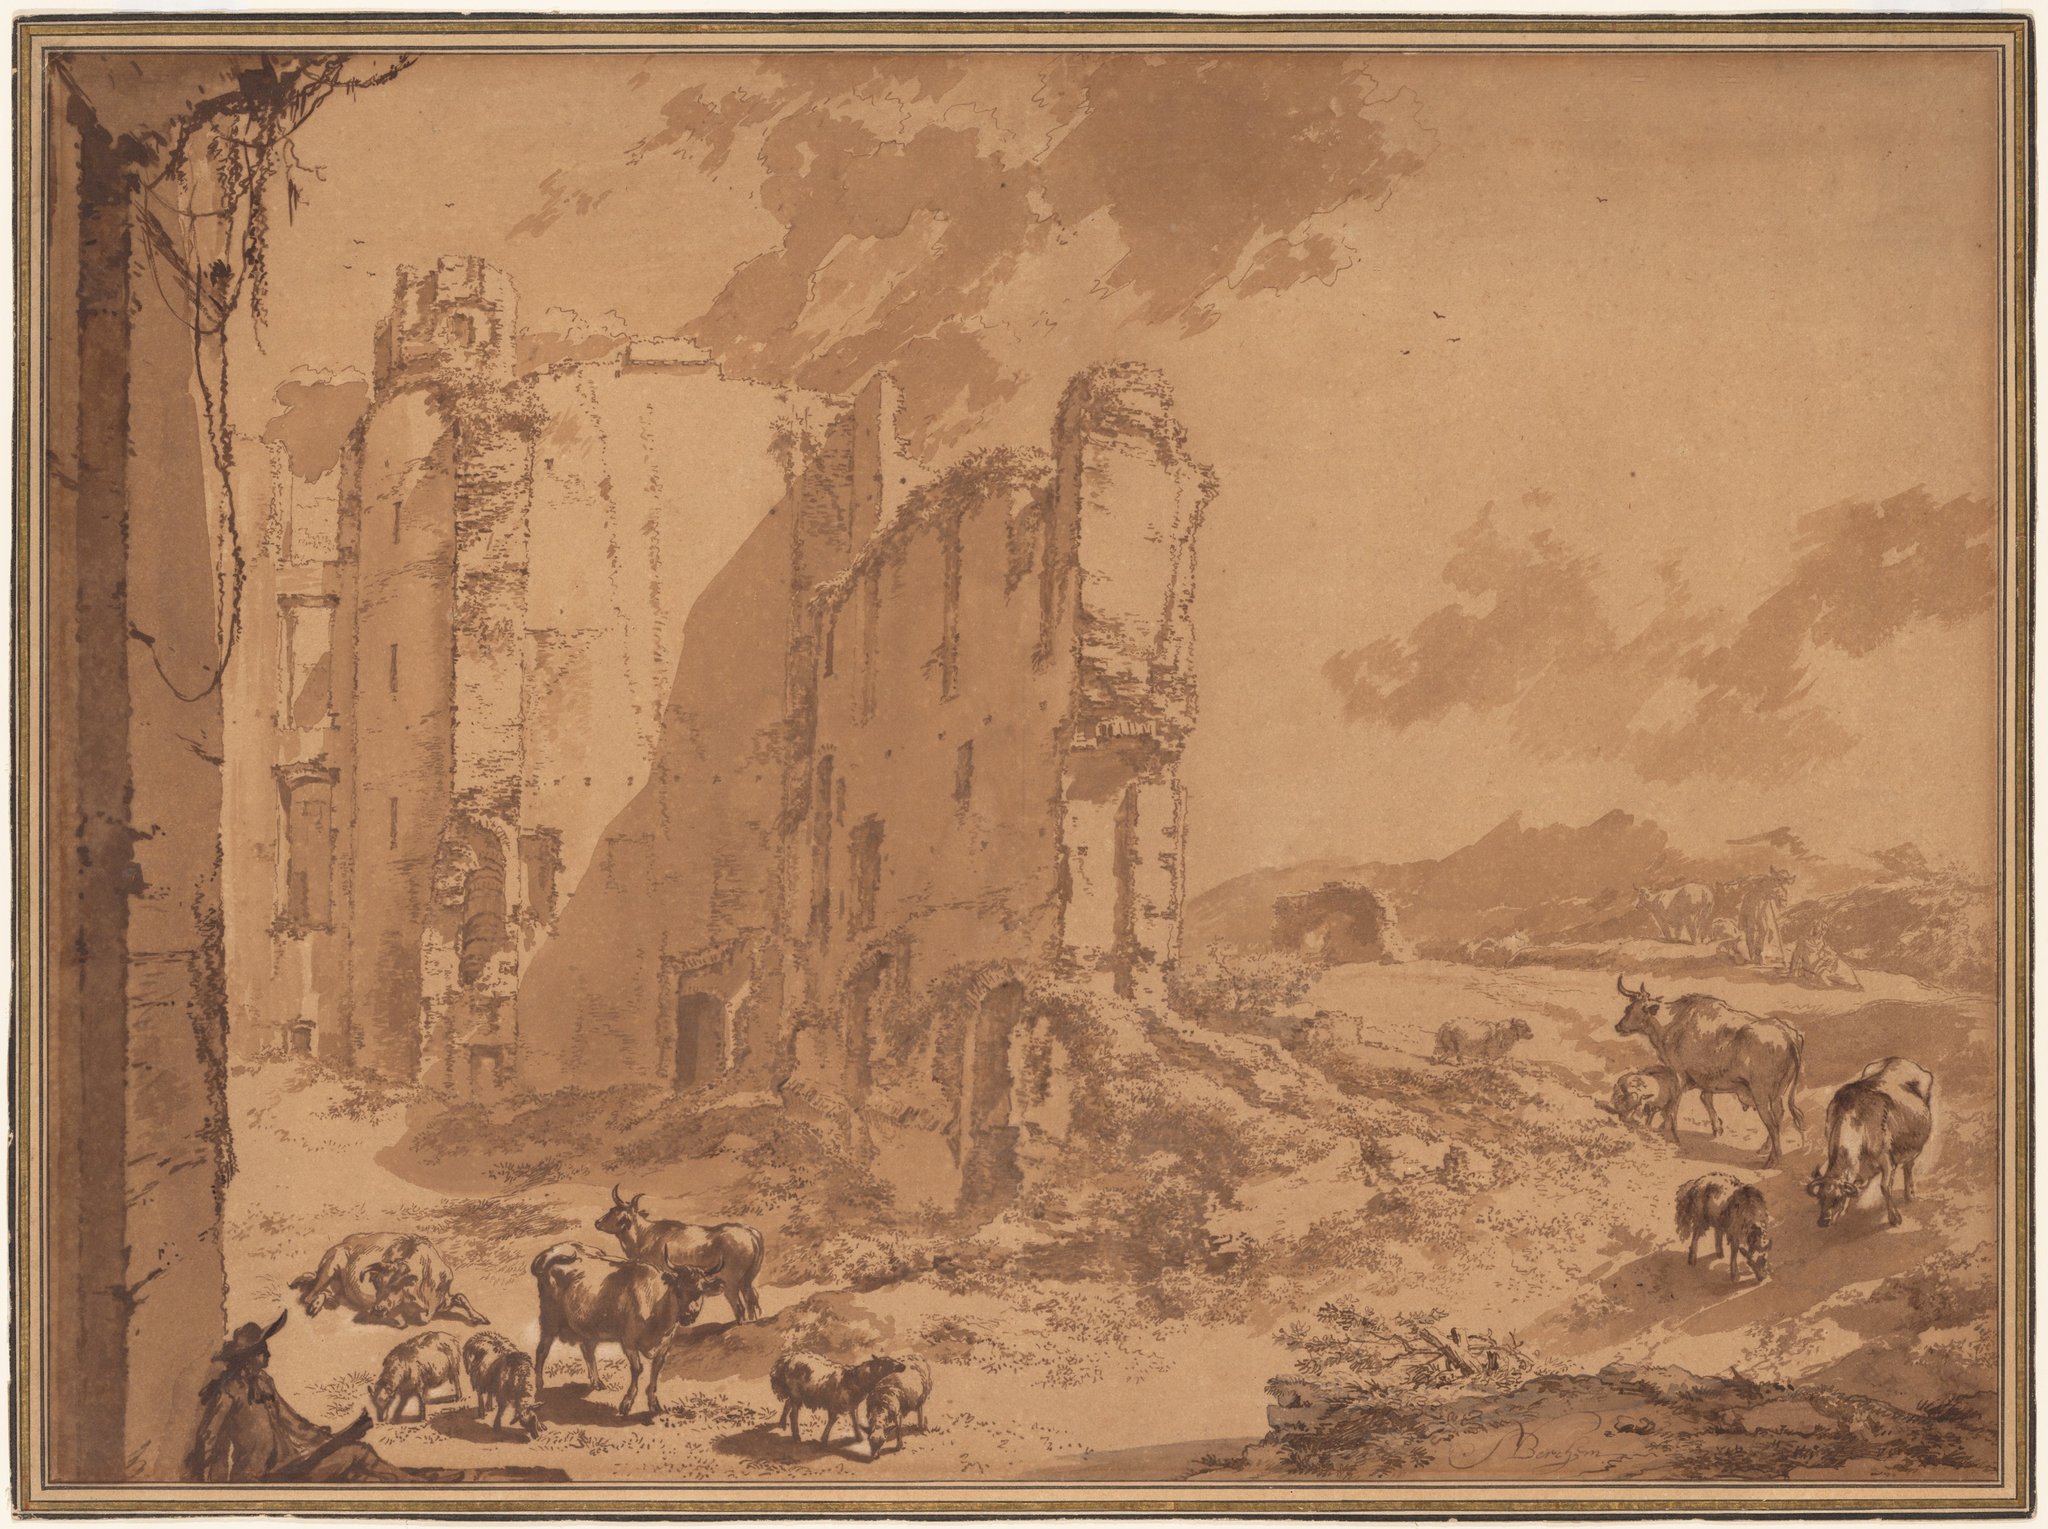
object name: drawing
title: Italianate Landscape with the Ruins of Brederode Castle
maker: nicolaes pietersz berchem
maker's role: artist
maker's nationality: dutch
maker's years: 1620-1683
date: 1634-1700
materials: ink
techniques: pen, wash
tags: animals,castles,ruins,landscapes